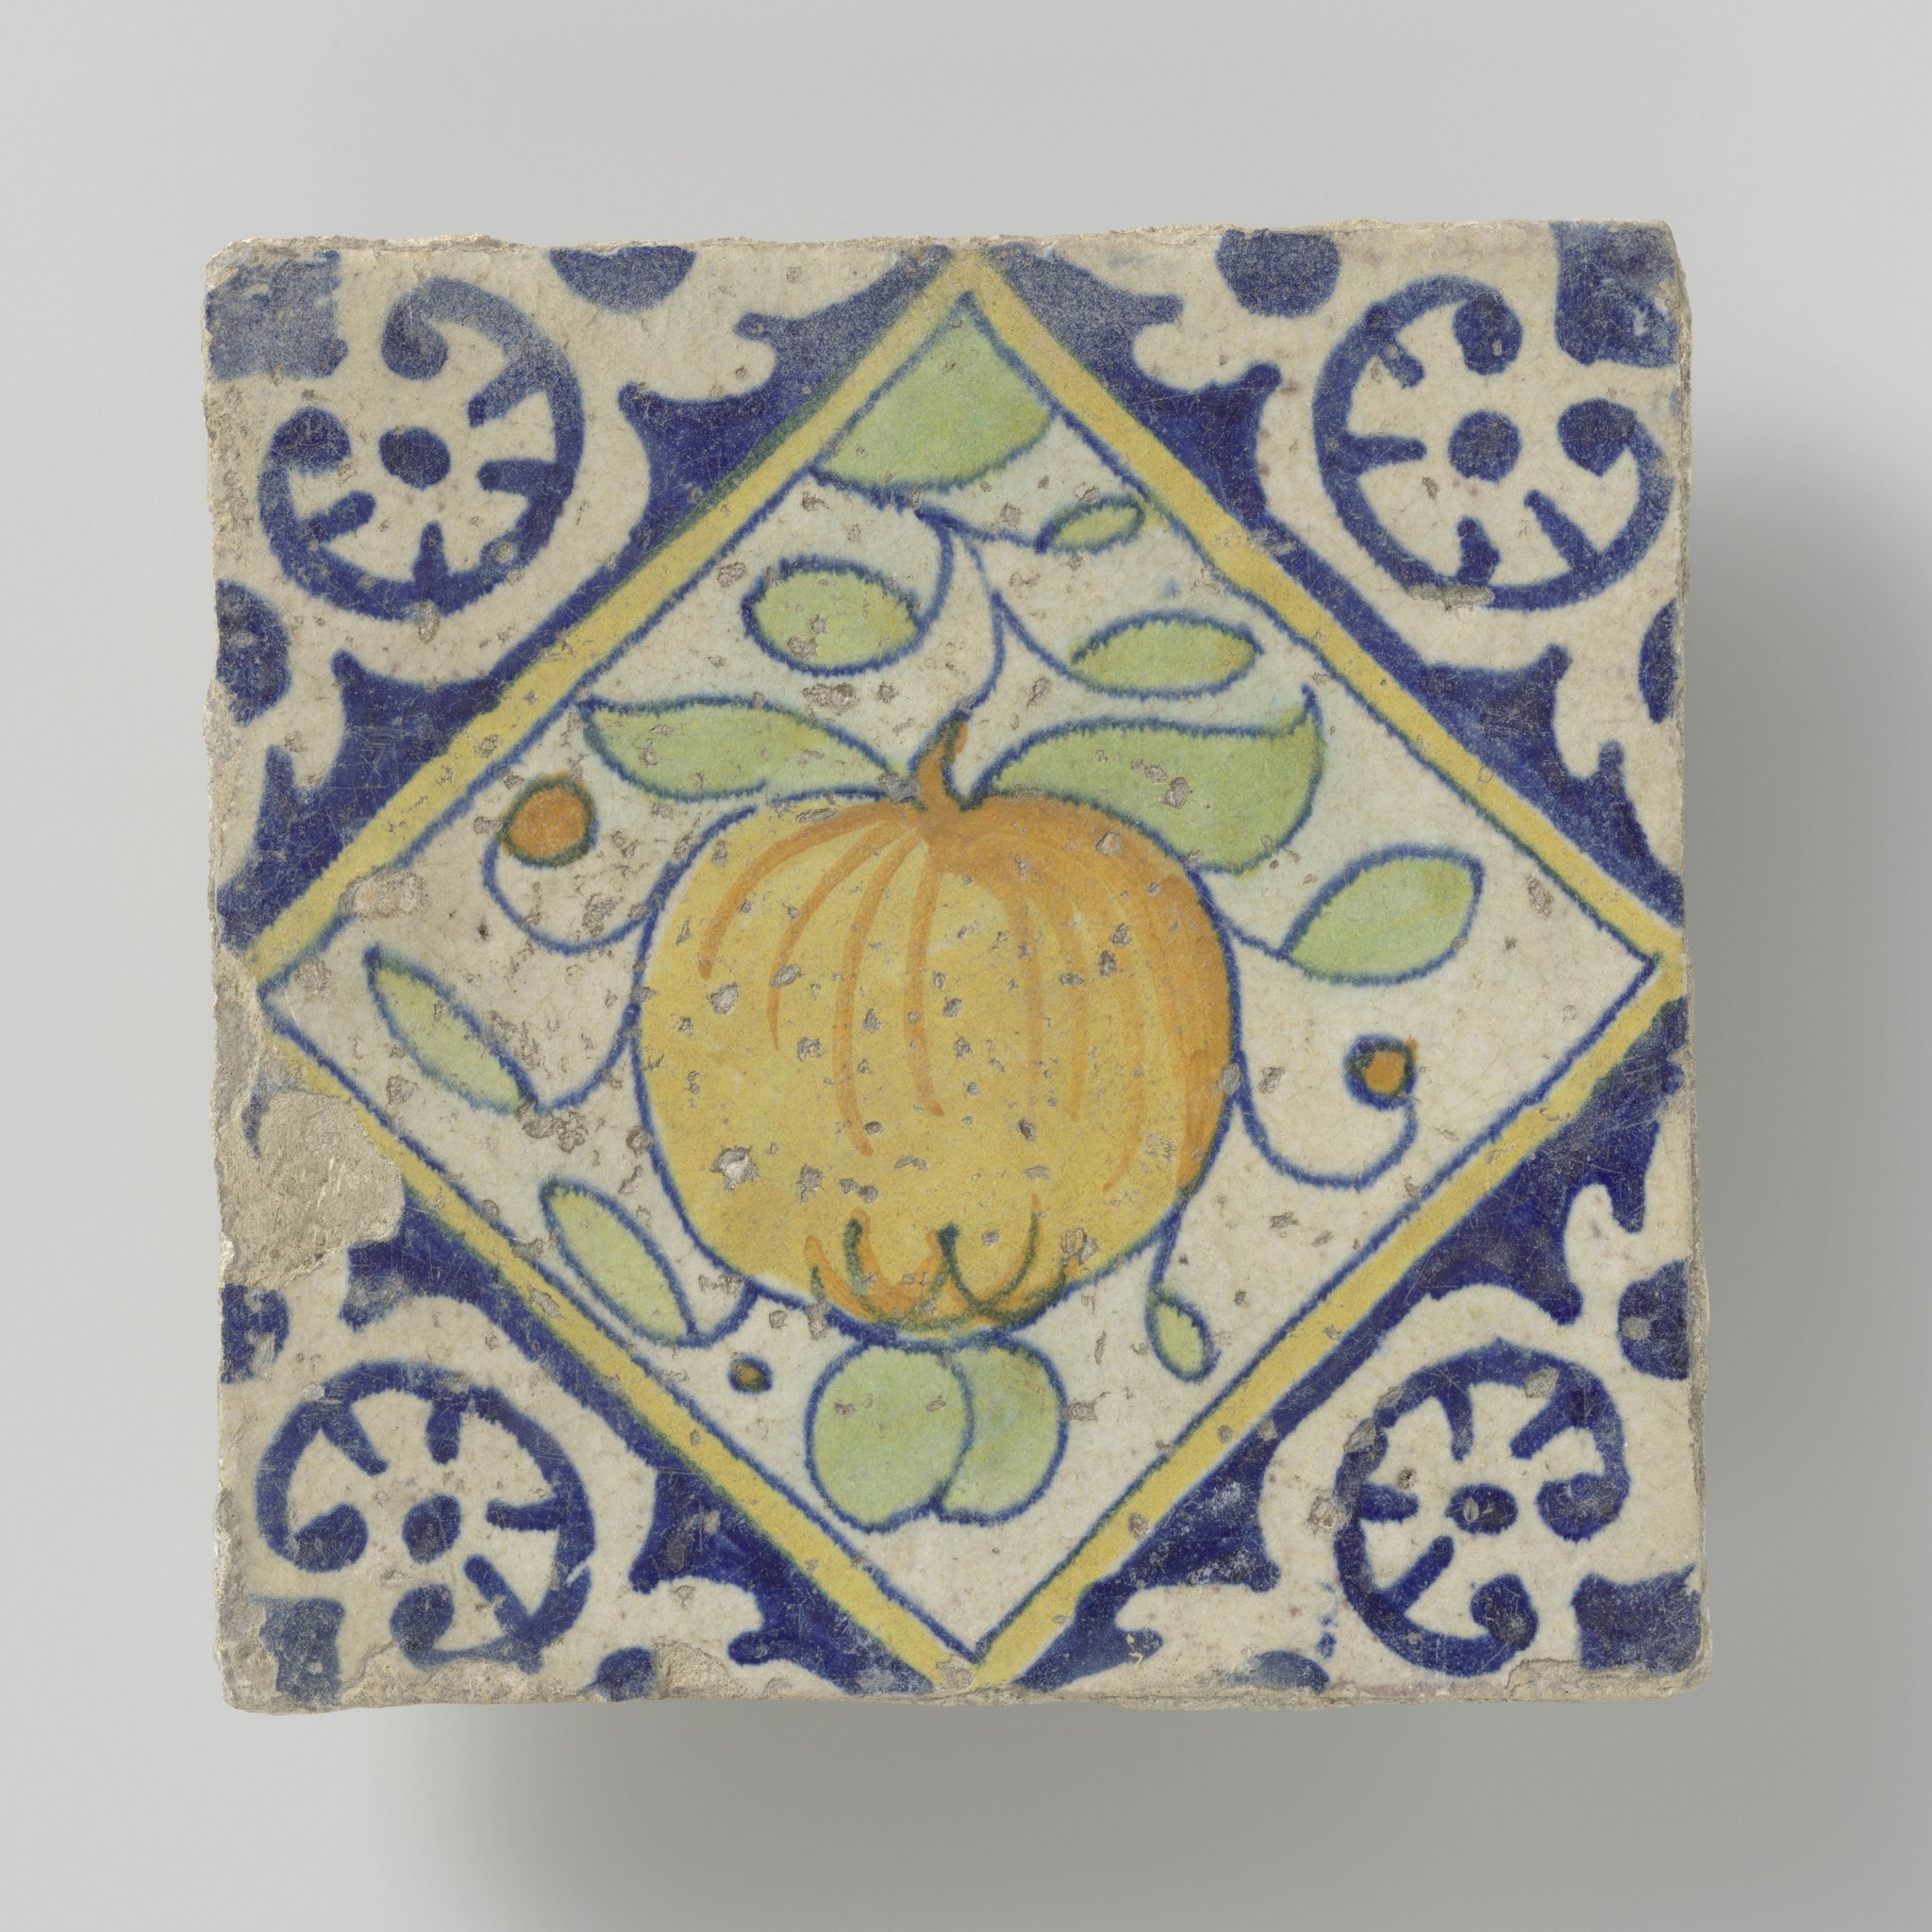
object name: tile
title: Tegel met granaatappel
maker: Anonymous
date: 1580-1625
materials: earthenware, glaze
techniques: maiolica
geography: netherlands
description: Tegel met een veelkleurig (blauw, oranje, geel en groen) geschilderde granaatappel met bladeren omlijst door een kwadraat met in de hoeken, ornament in vultechniek.